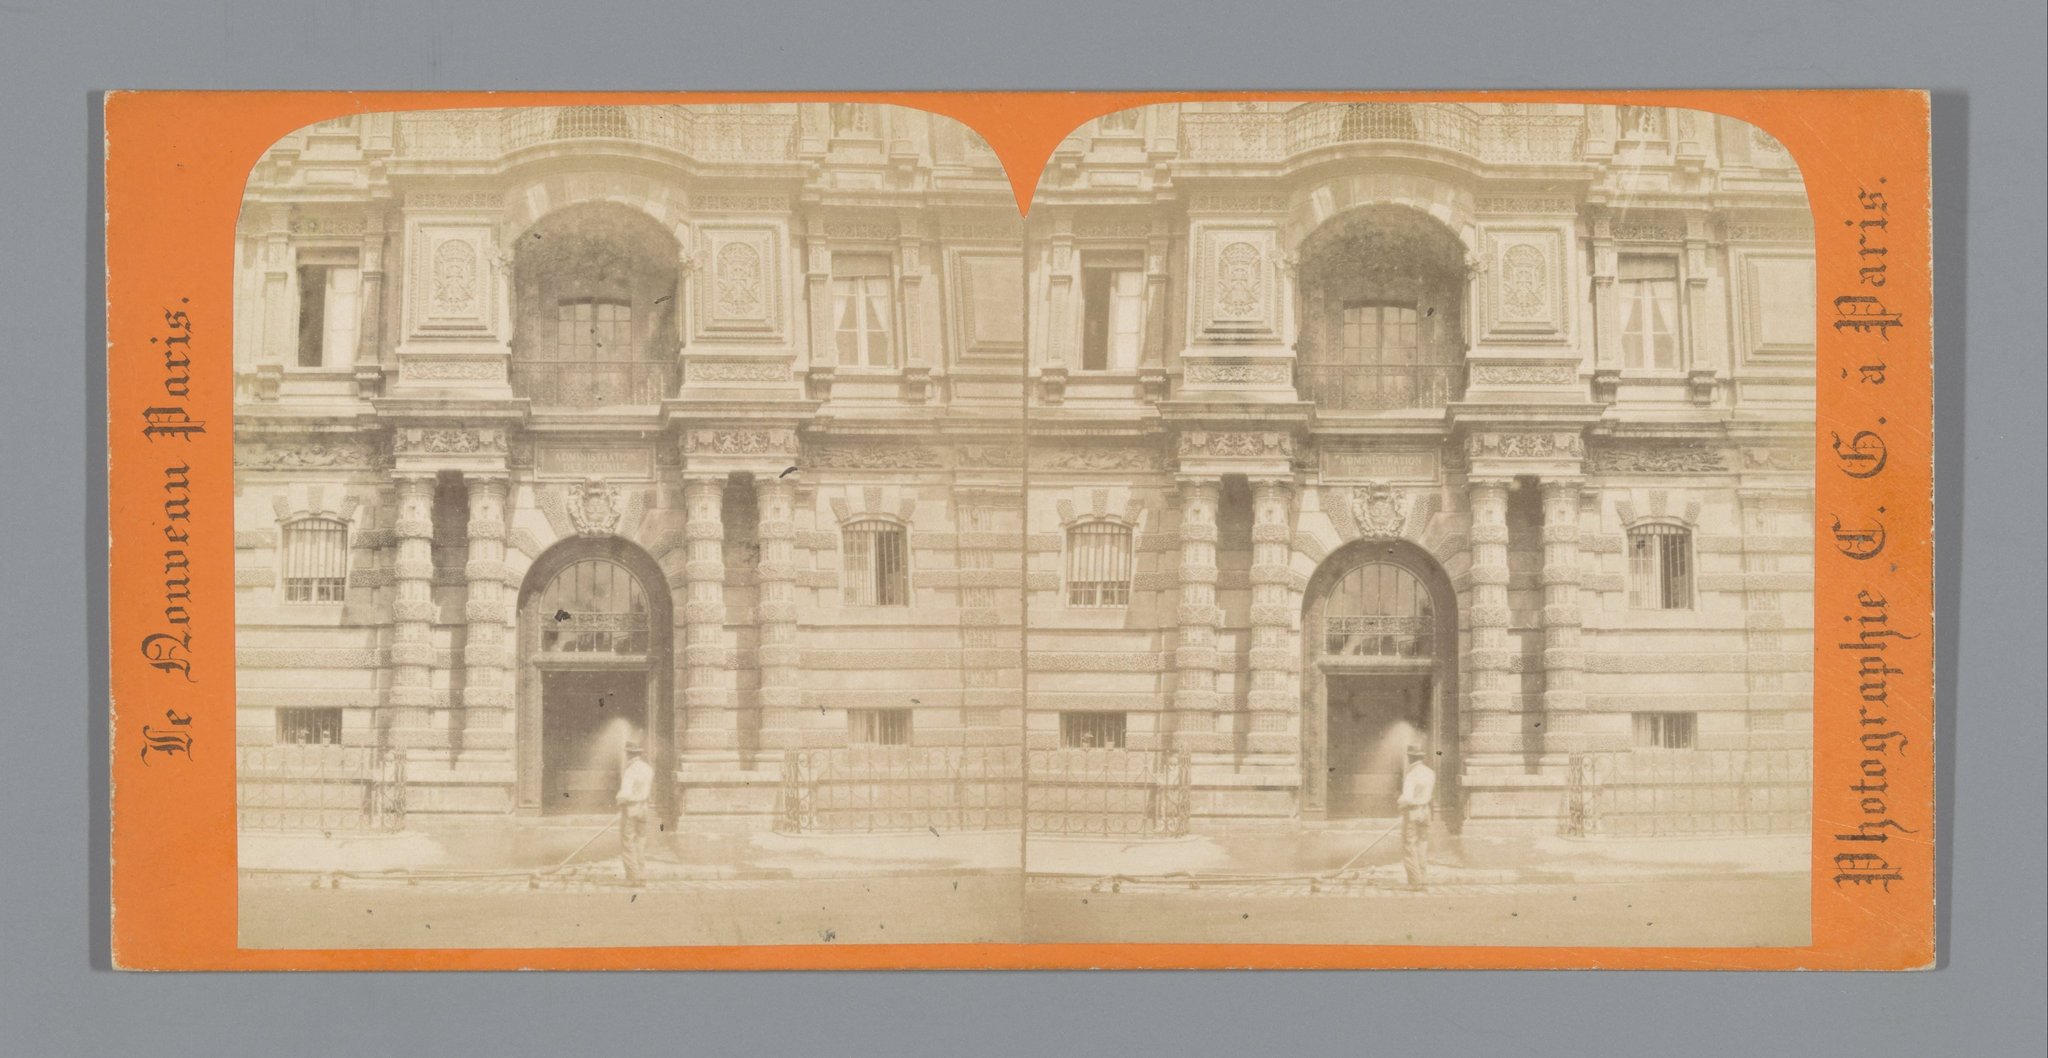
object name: stereograph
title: Le Nouveau Paris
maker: charles gérard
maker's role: fotograaf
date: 1850-1875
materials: cardboard, photographic support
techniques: albumen print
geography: paris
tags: façade (of house or building), stall, stable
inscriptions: inscription: ‘Administration des ecuries de l'Empereur’